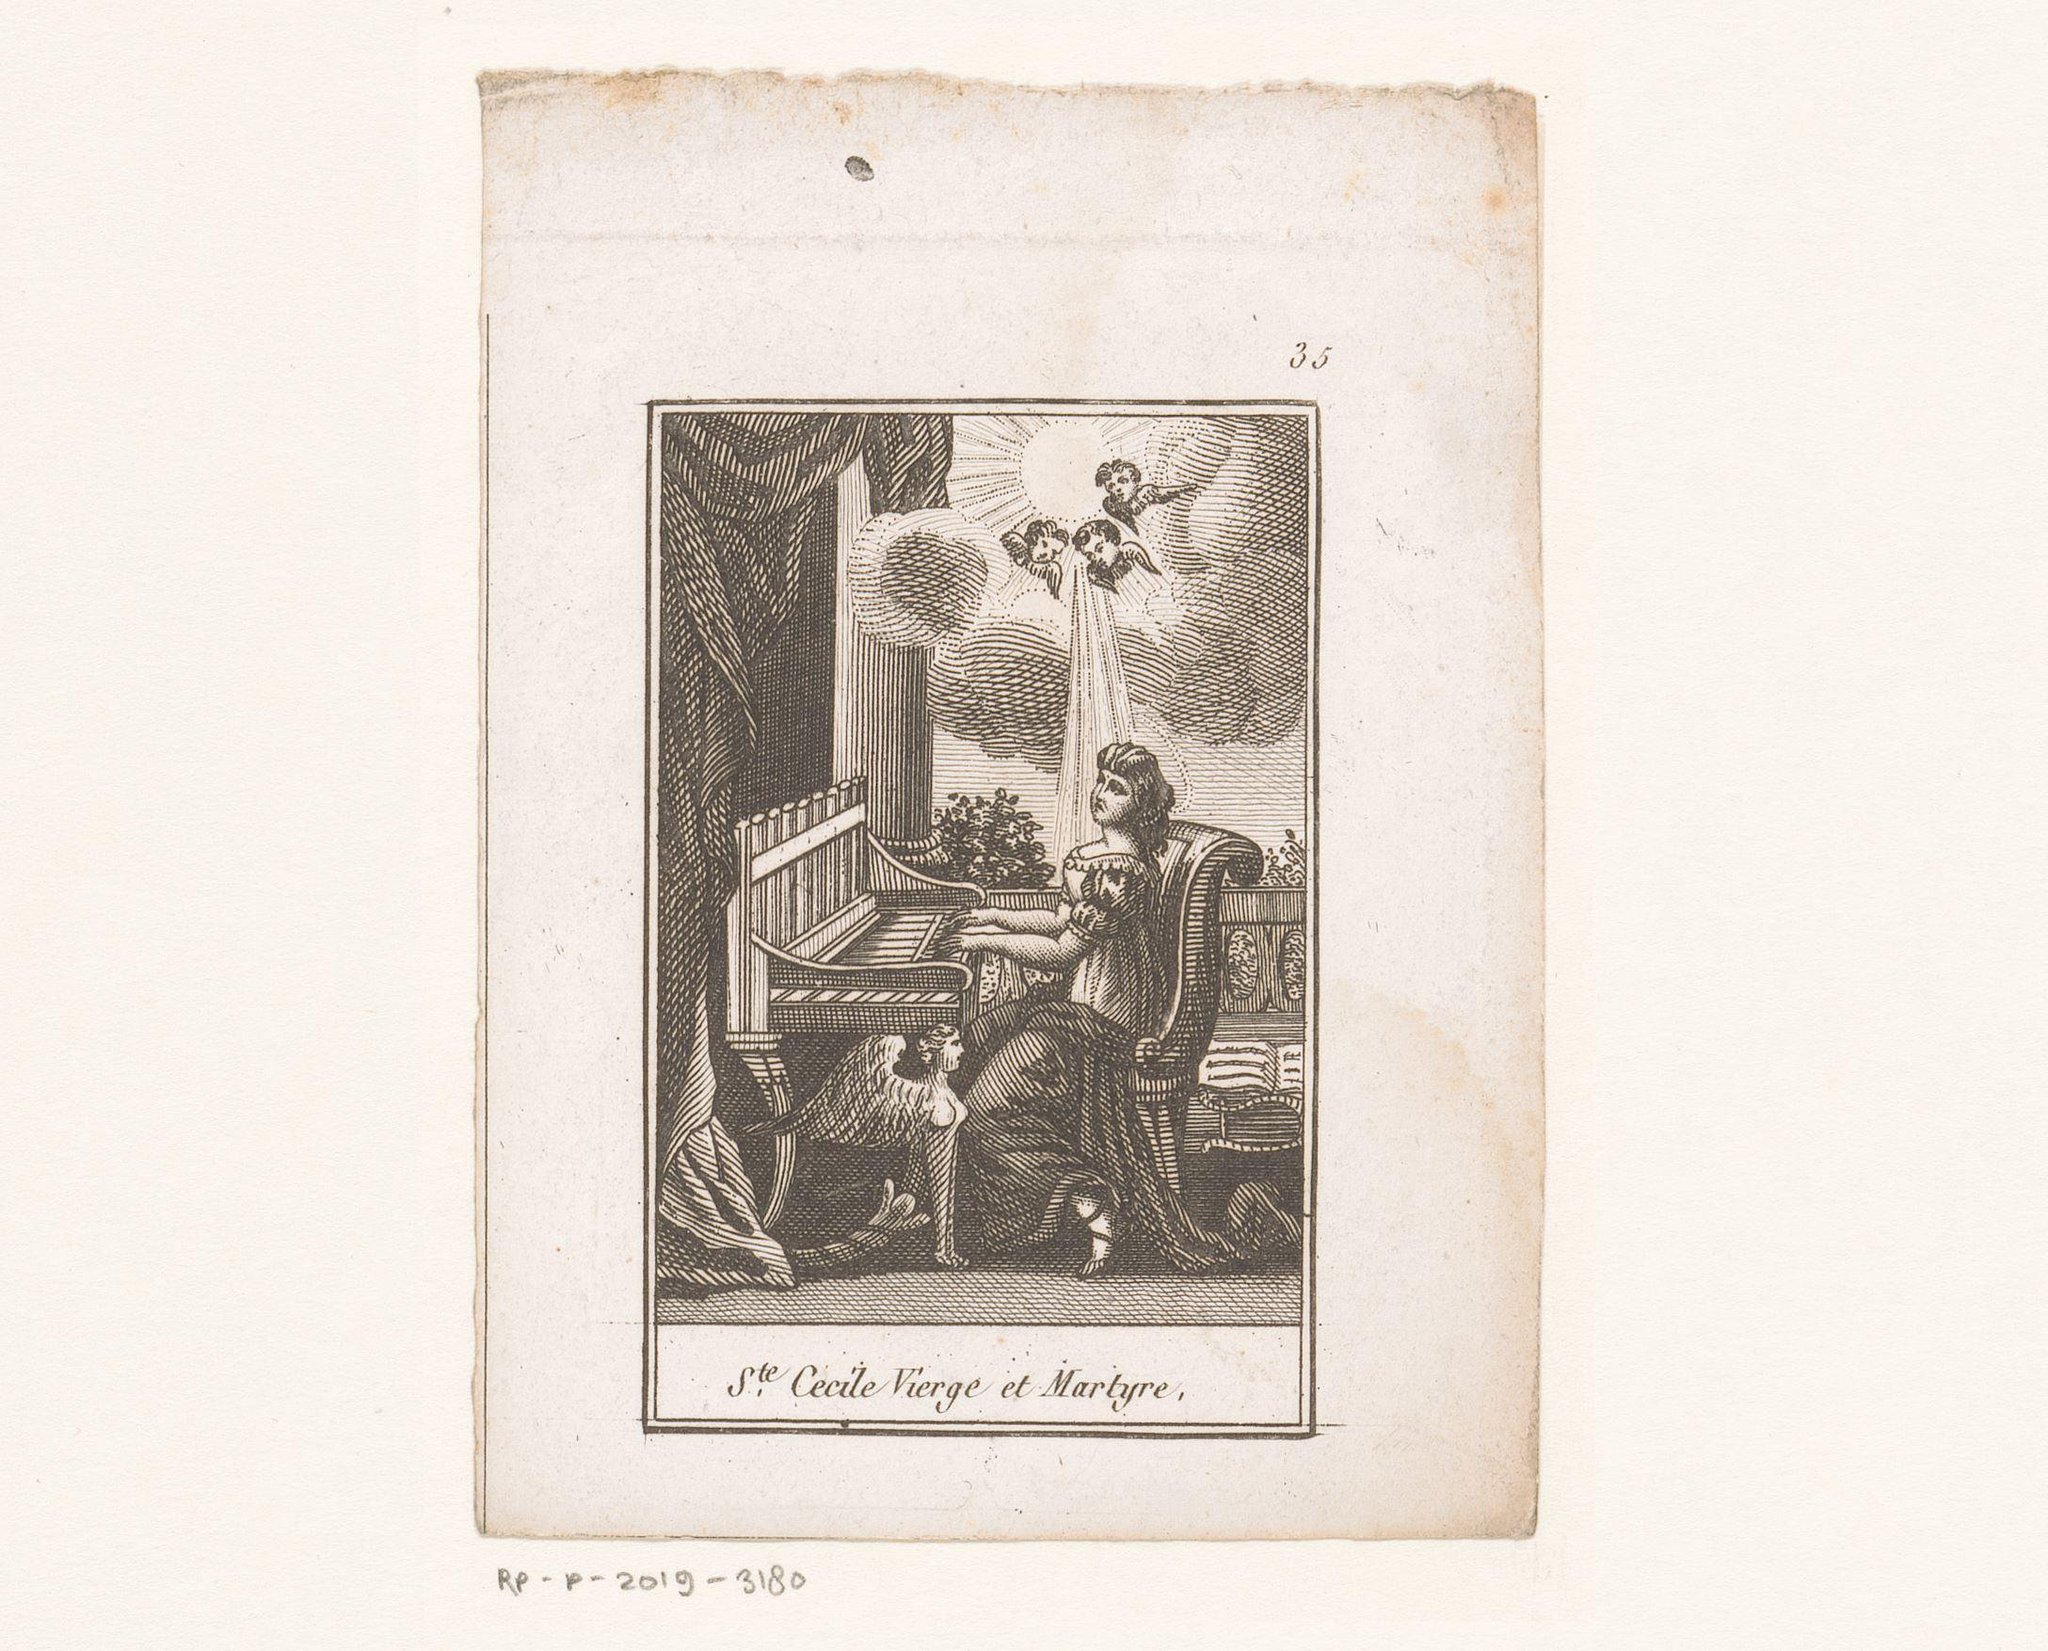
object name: print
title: H. Cecilia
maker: Anonymous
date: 1700-1799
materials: paper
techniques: etching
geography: france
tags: the virgin martyr cecilia of rome; possible attributes: falcon, musical instruments, organ, wreath of roses and lilies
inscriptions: collector's mark: Lugt 2228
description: Mogelijk betreft dit een prent uit een onbekend boek.